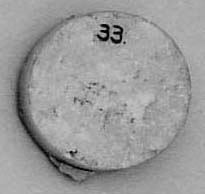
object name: fragment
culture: burmese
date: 1902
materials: jade